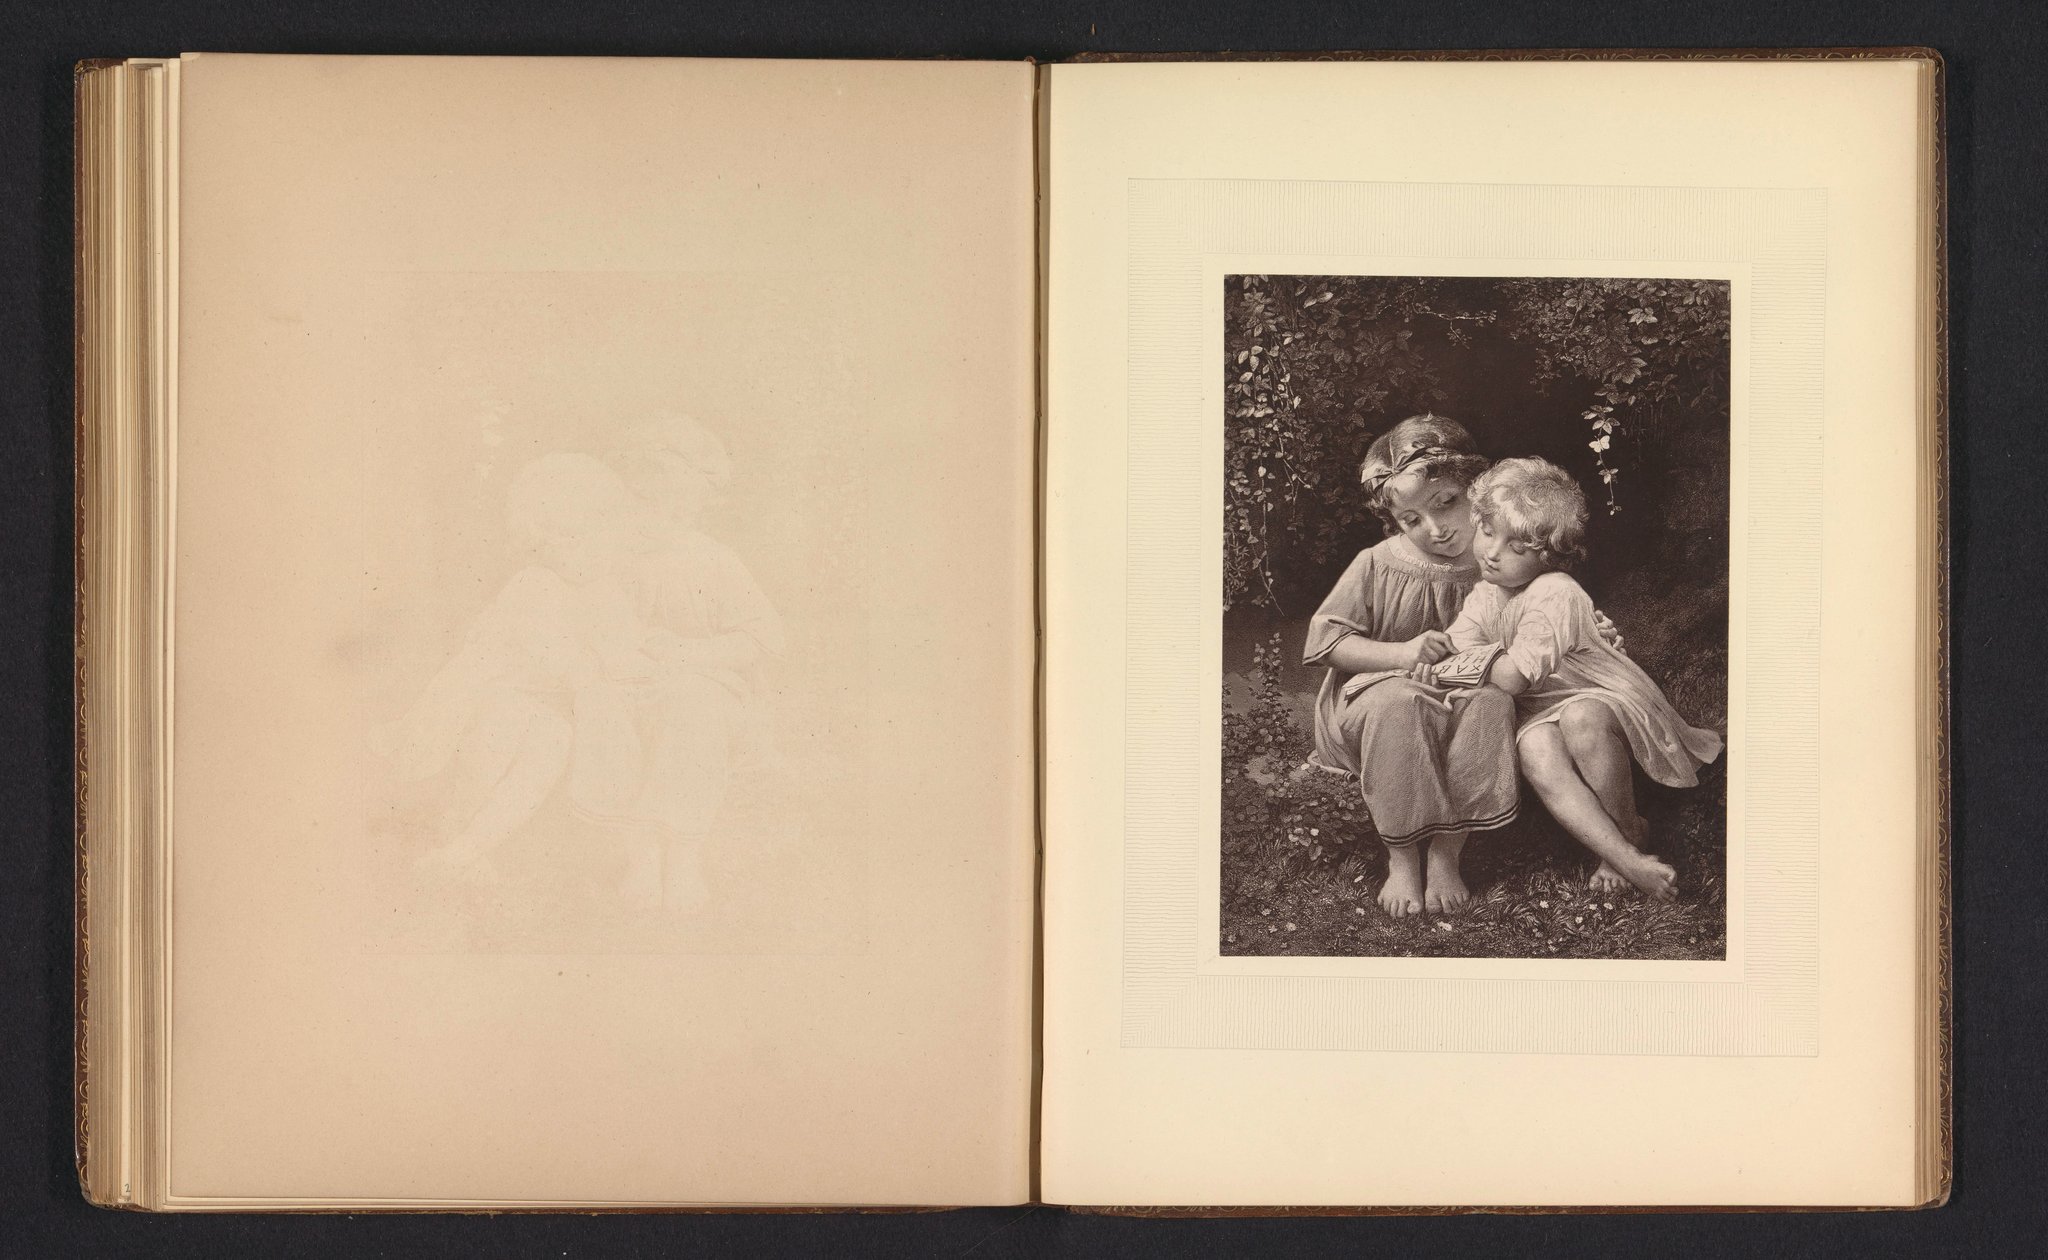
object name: reproduction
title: Fotoreproductie van een prent naar een schilderij van twee lezende kinderen door Léon Perrault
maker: Anonymous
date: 1864-1874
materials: paper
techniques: woodburytype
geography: london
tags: reading, picture, painting